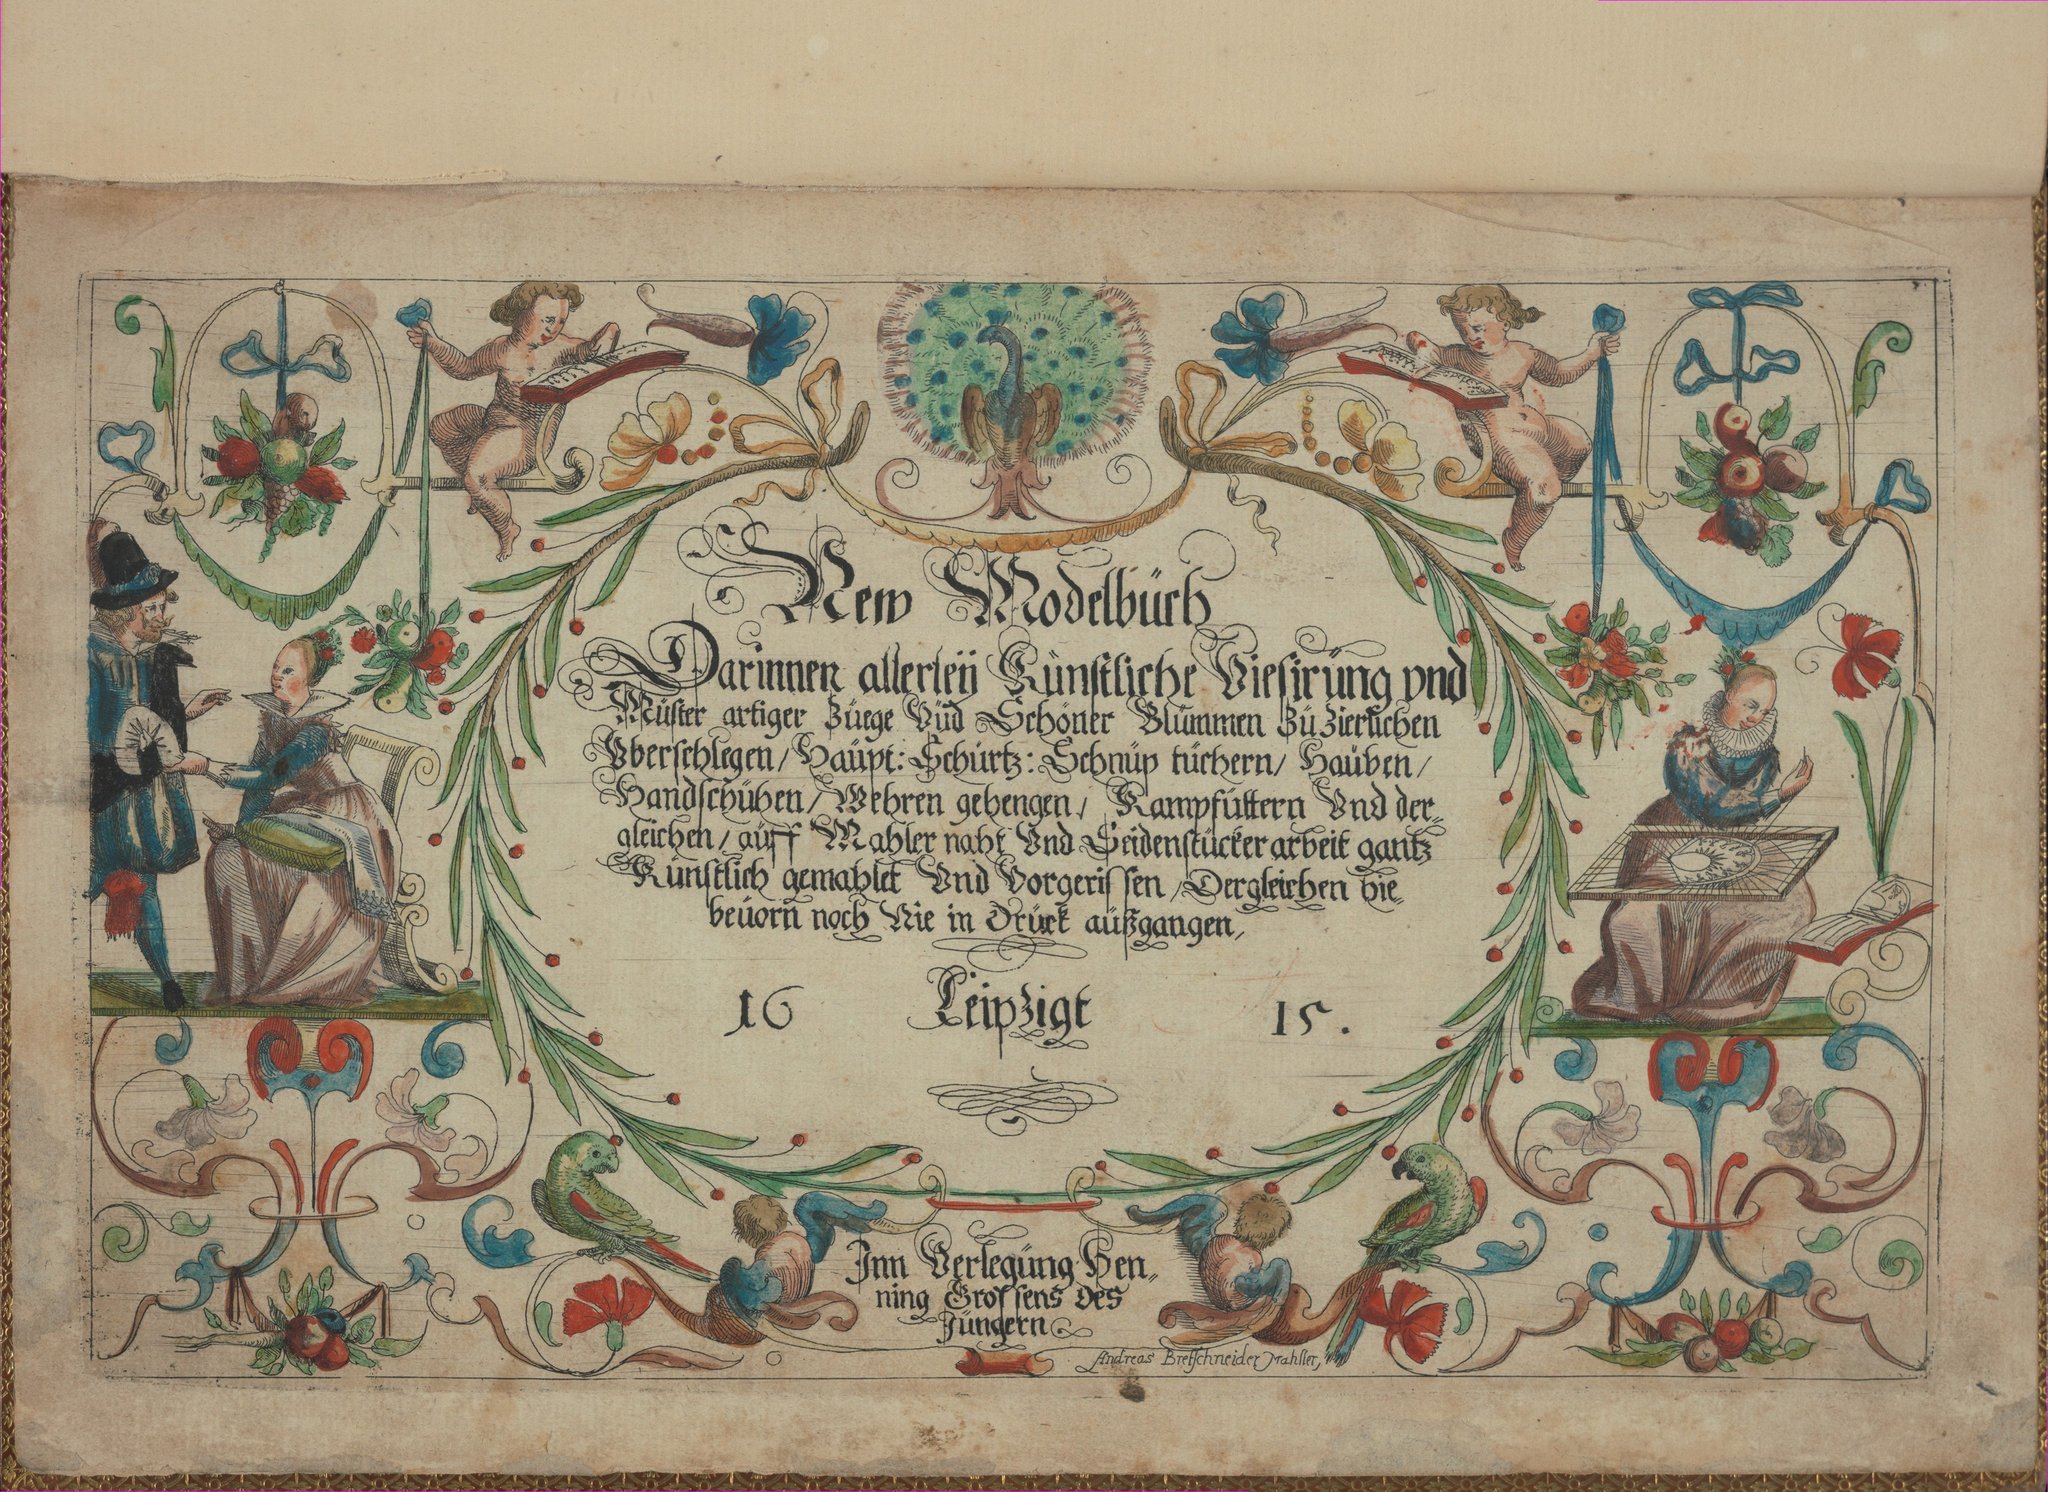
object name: ornament architecture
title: New Modelbüch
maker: andreas bretschneider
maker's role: designer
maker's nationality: german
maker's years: 1573-1645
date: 1615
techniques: etching, woodcut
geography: germany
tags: men,women,peacocks,coat of arms